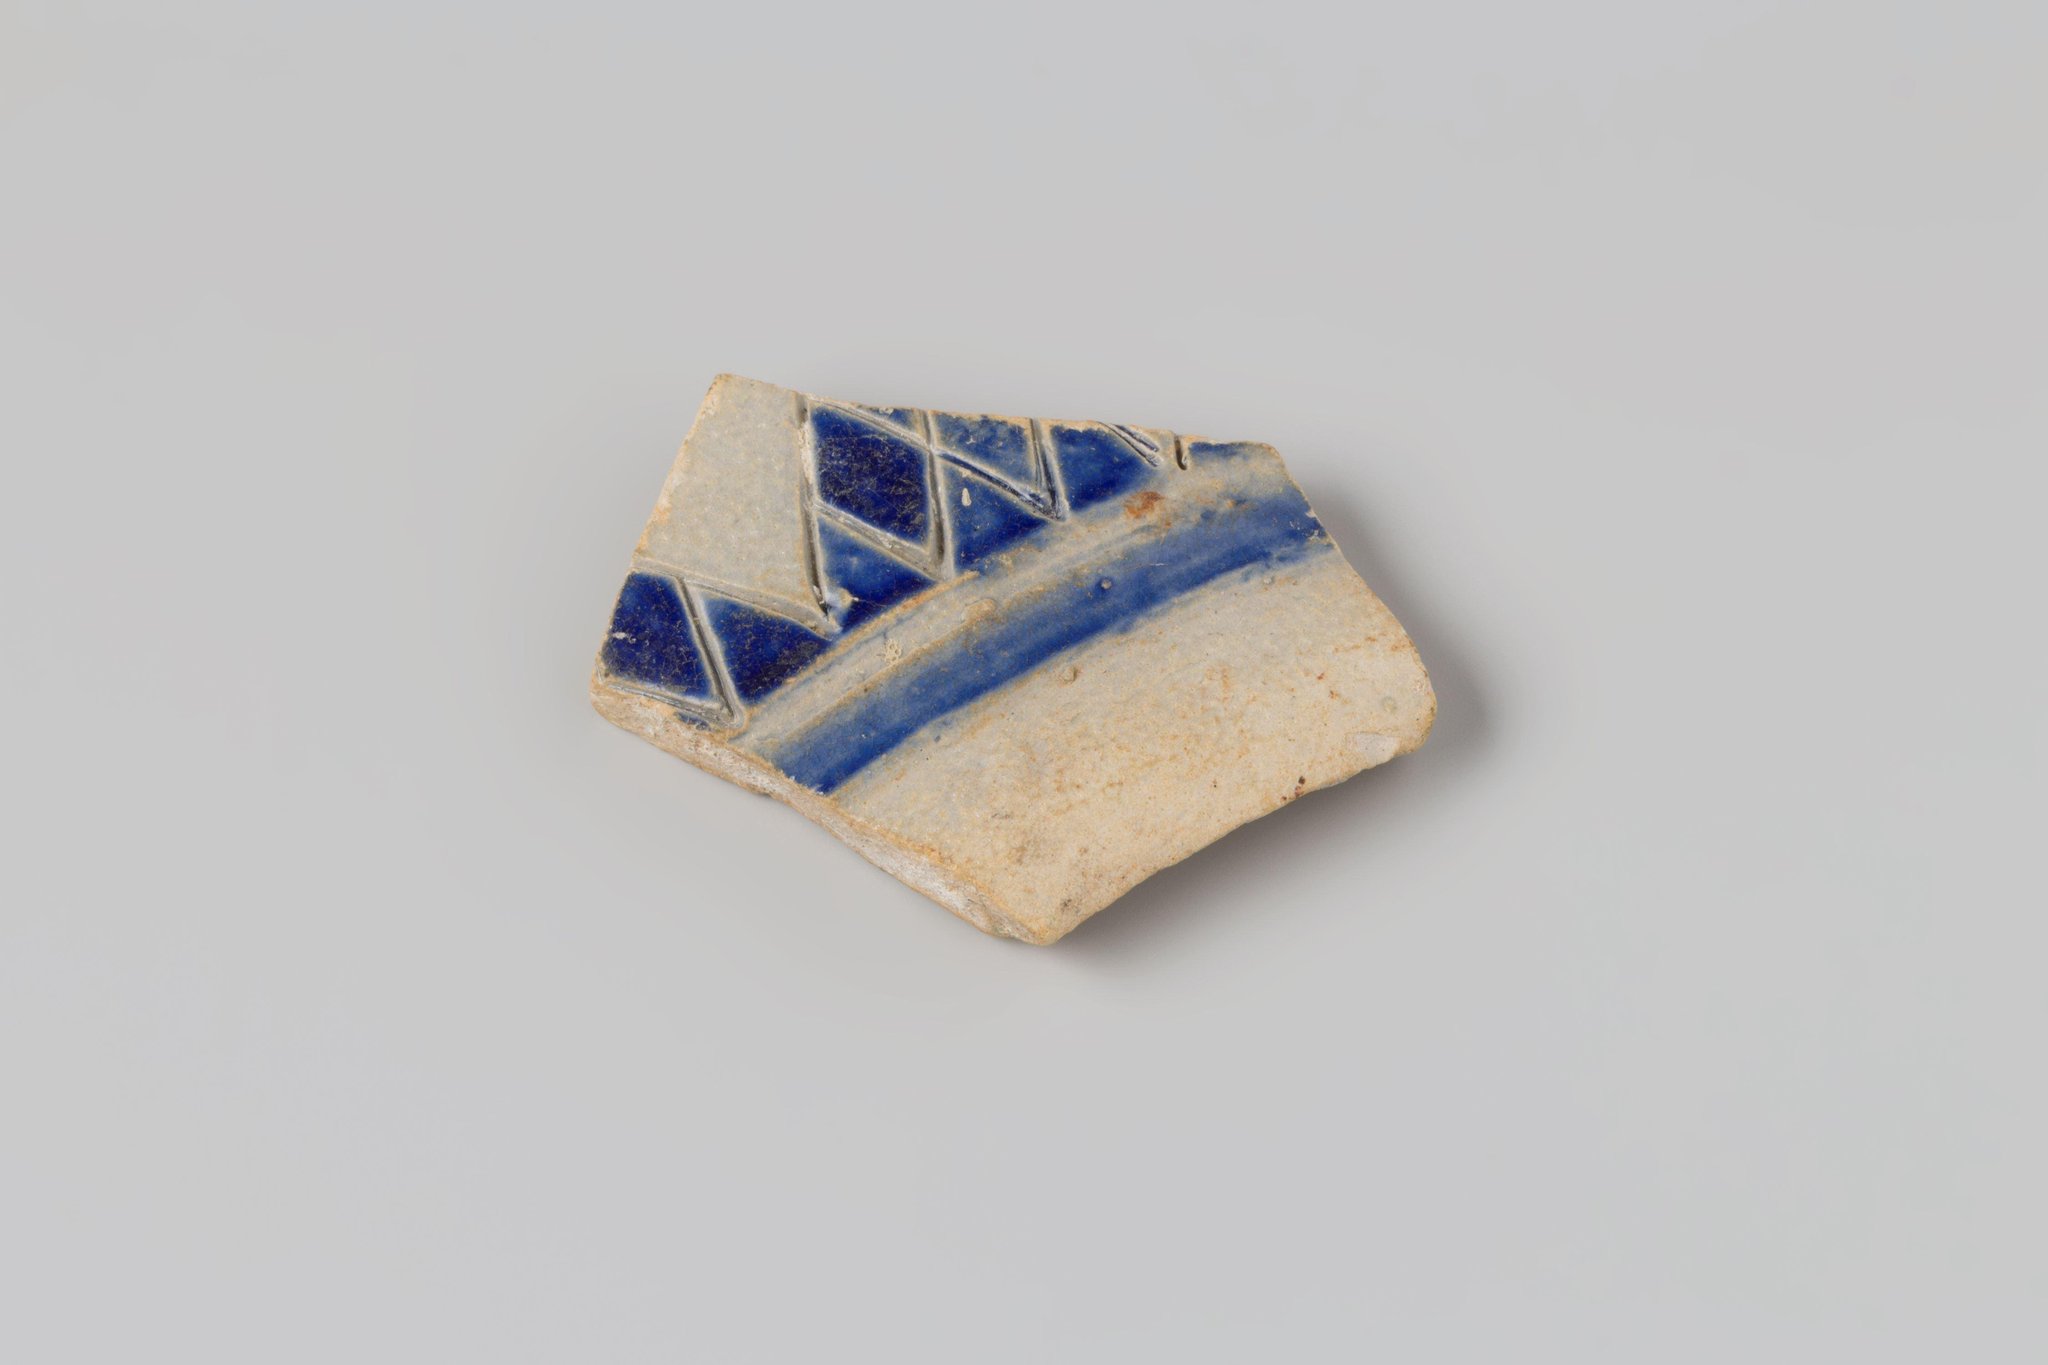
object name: pot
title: Scherf van een pot uit het wrak van de Oost-Indiëvaarder Hollandia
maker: Anonymous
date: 1700-1743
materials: stoneware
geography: westerwald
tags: verenigde oostindische compagnie, hollandia (schip), annet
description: Stoneware, Rhenish, Westerwald, pot; of body, sim. NG 1980-27H2624r.